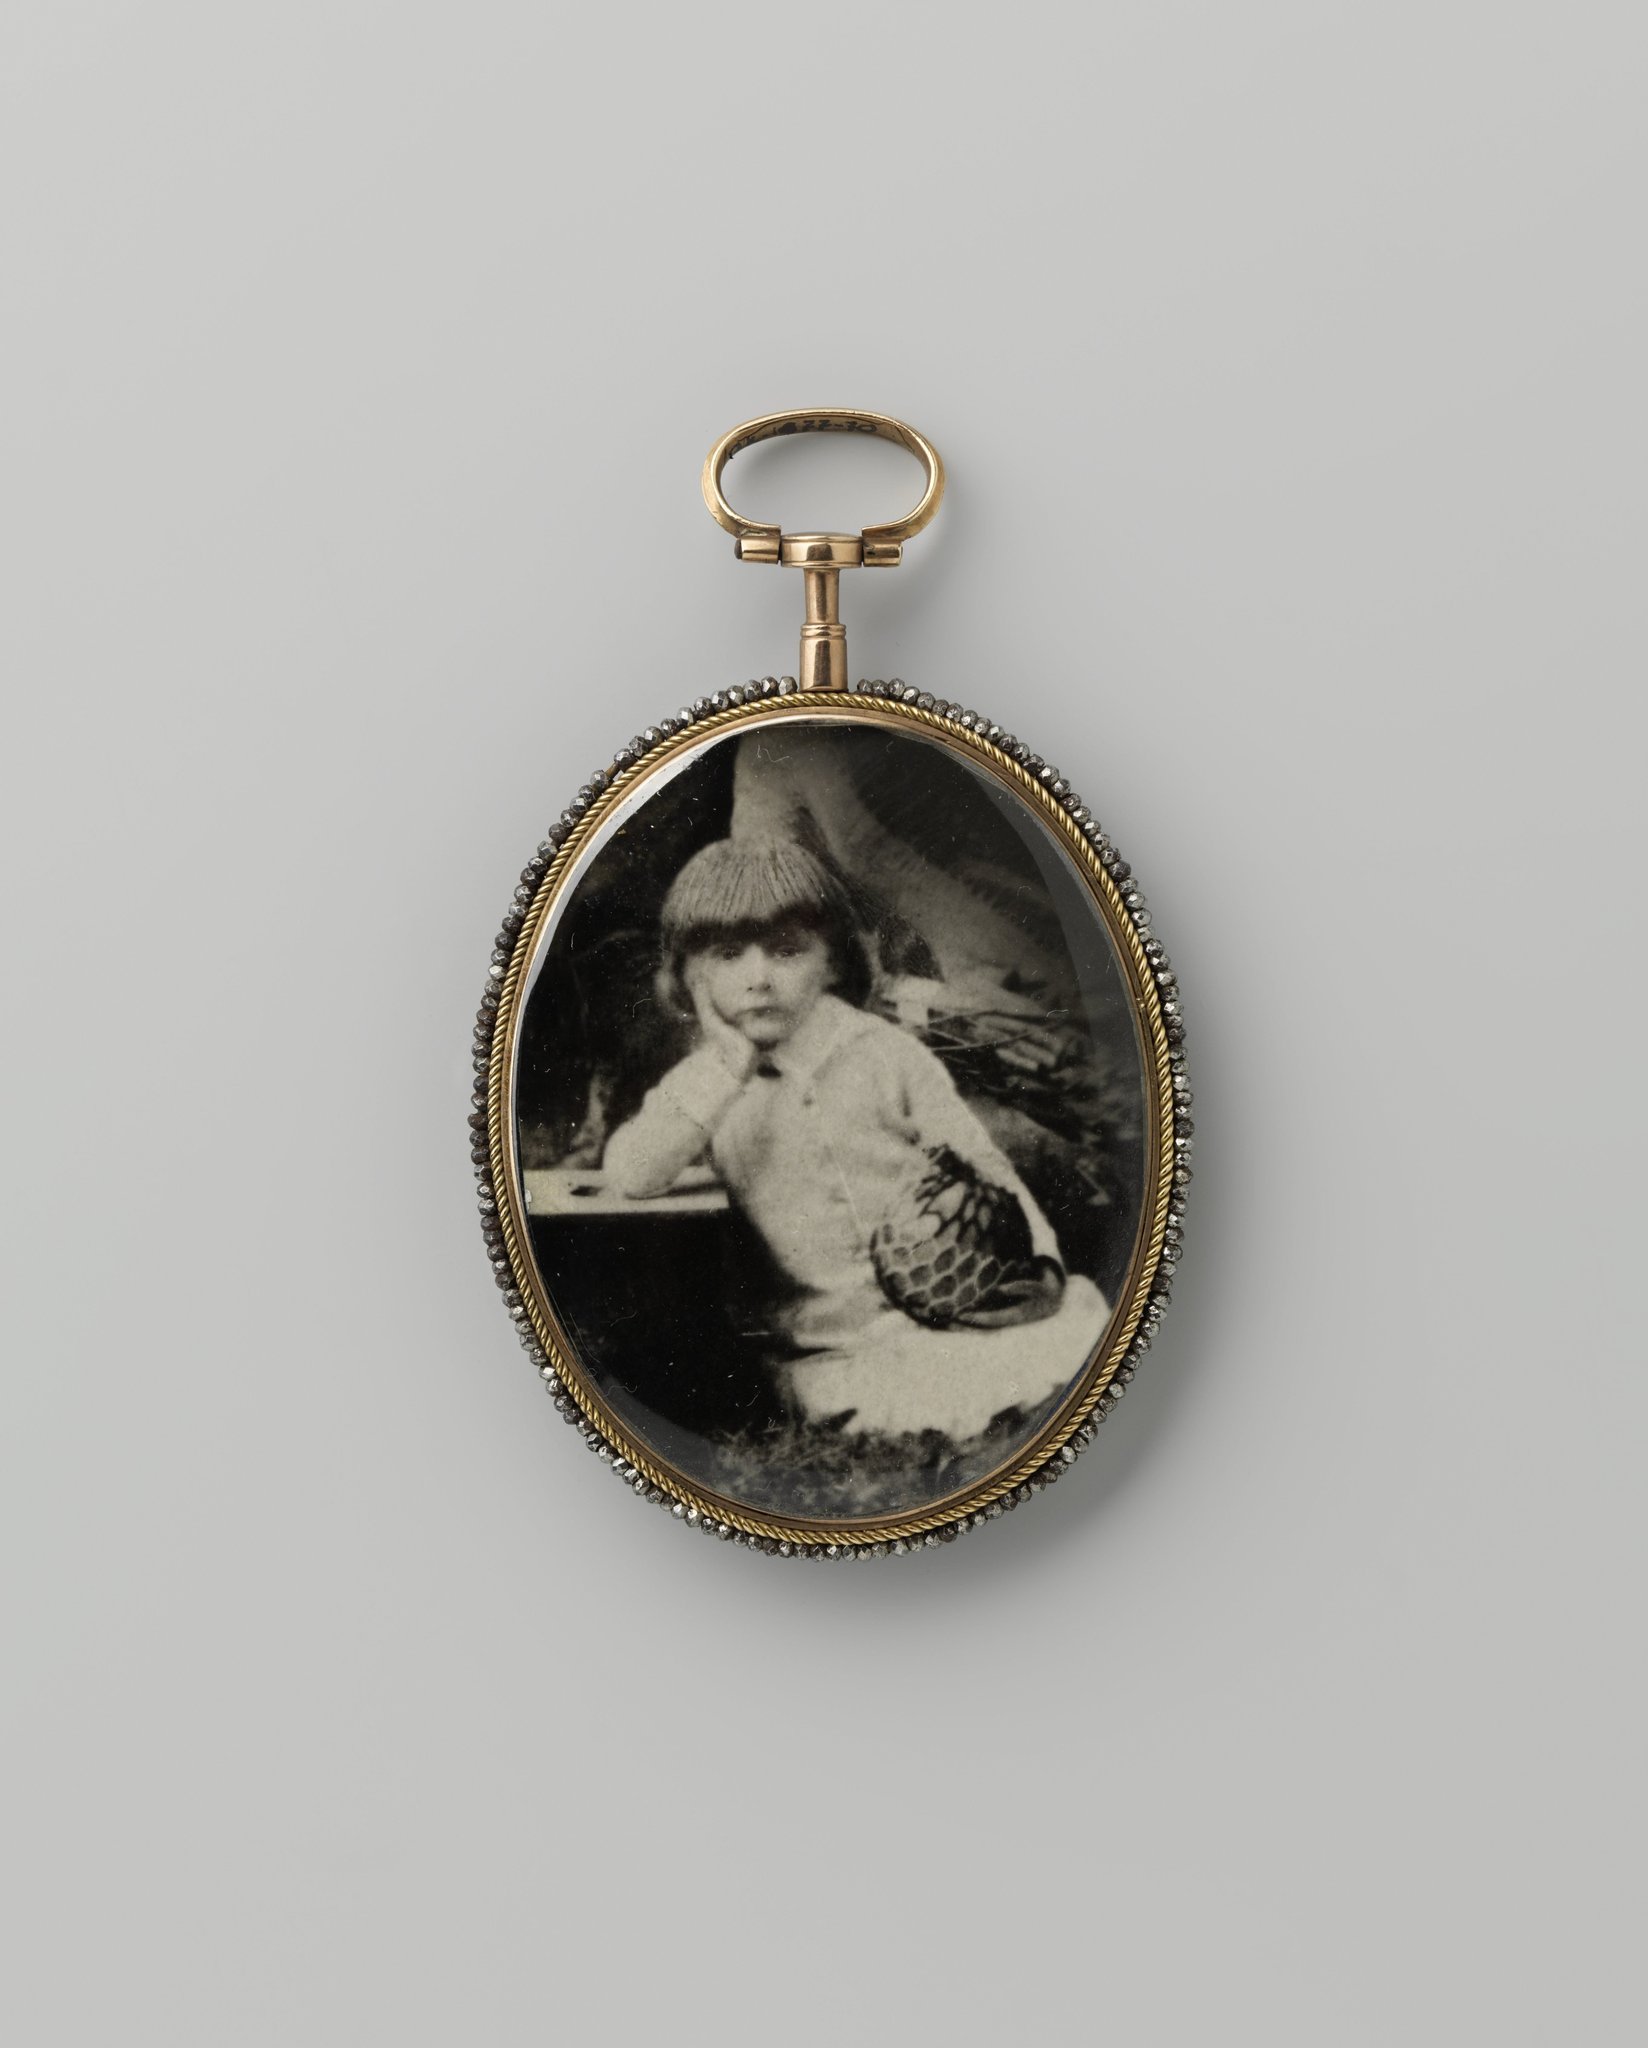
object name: locket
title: Portretmedaillon van goud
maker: Anonymous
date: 1870-1900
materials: glass, gold, hair, paste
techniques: engine turning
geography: netherlands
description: Portretmedaillon van goud, ovaal, met rand van goud, bezet met strass. Aan voorzijde een fotografisch portret; aan de achterzijde een medaillon waarin een haarlok achter glas omgeven door een rand van blauw glas op geguillocheerde grond.